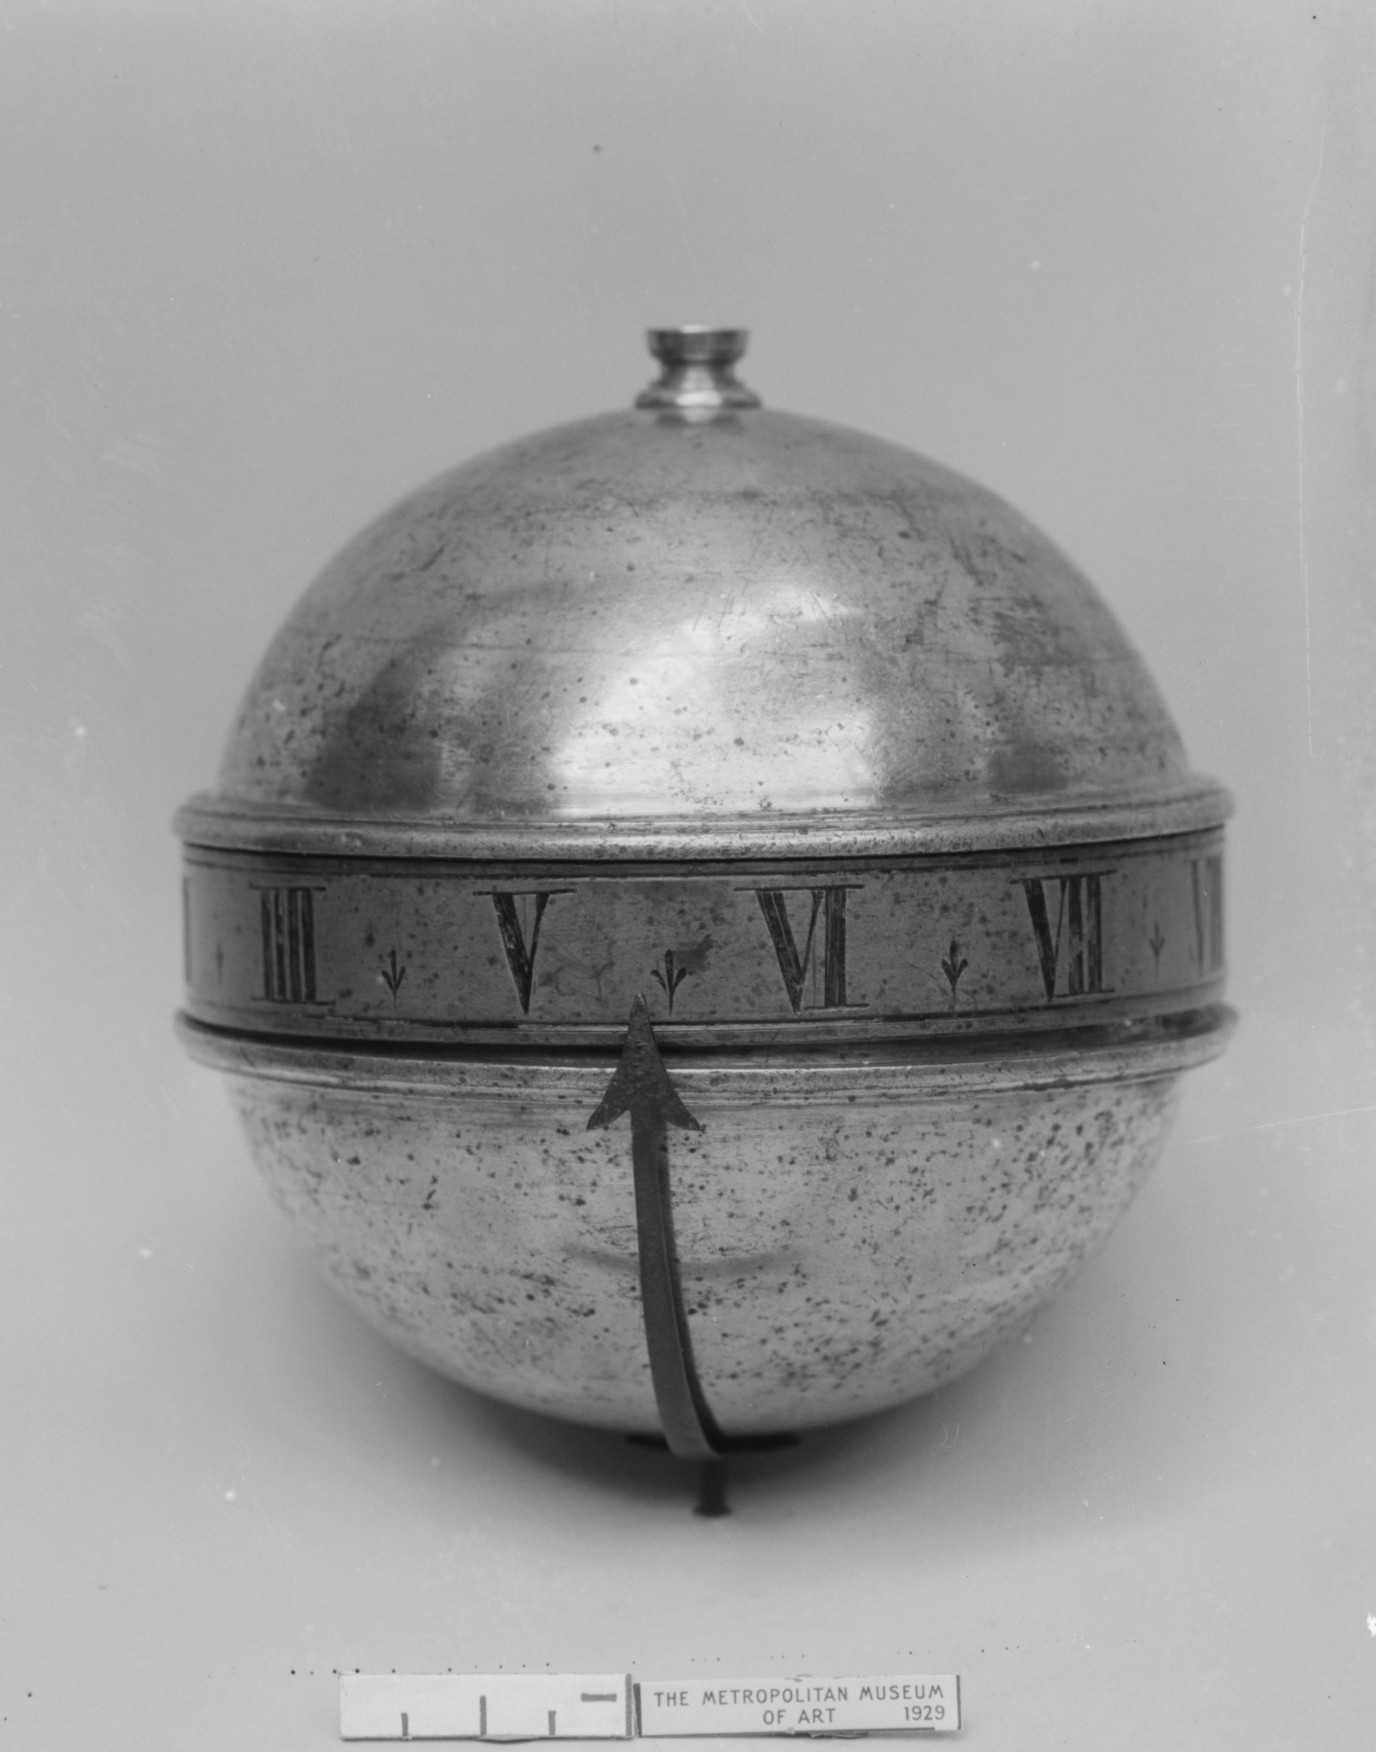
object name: clock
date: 1667-1700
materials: gilt bronze